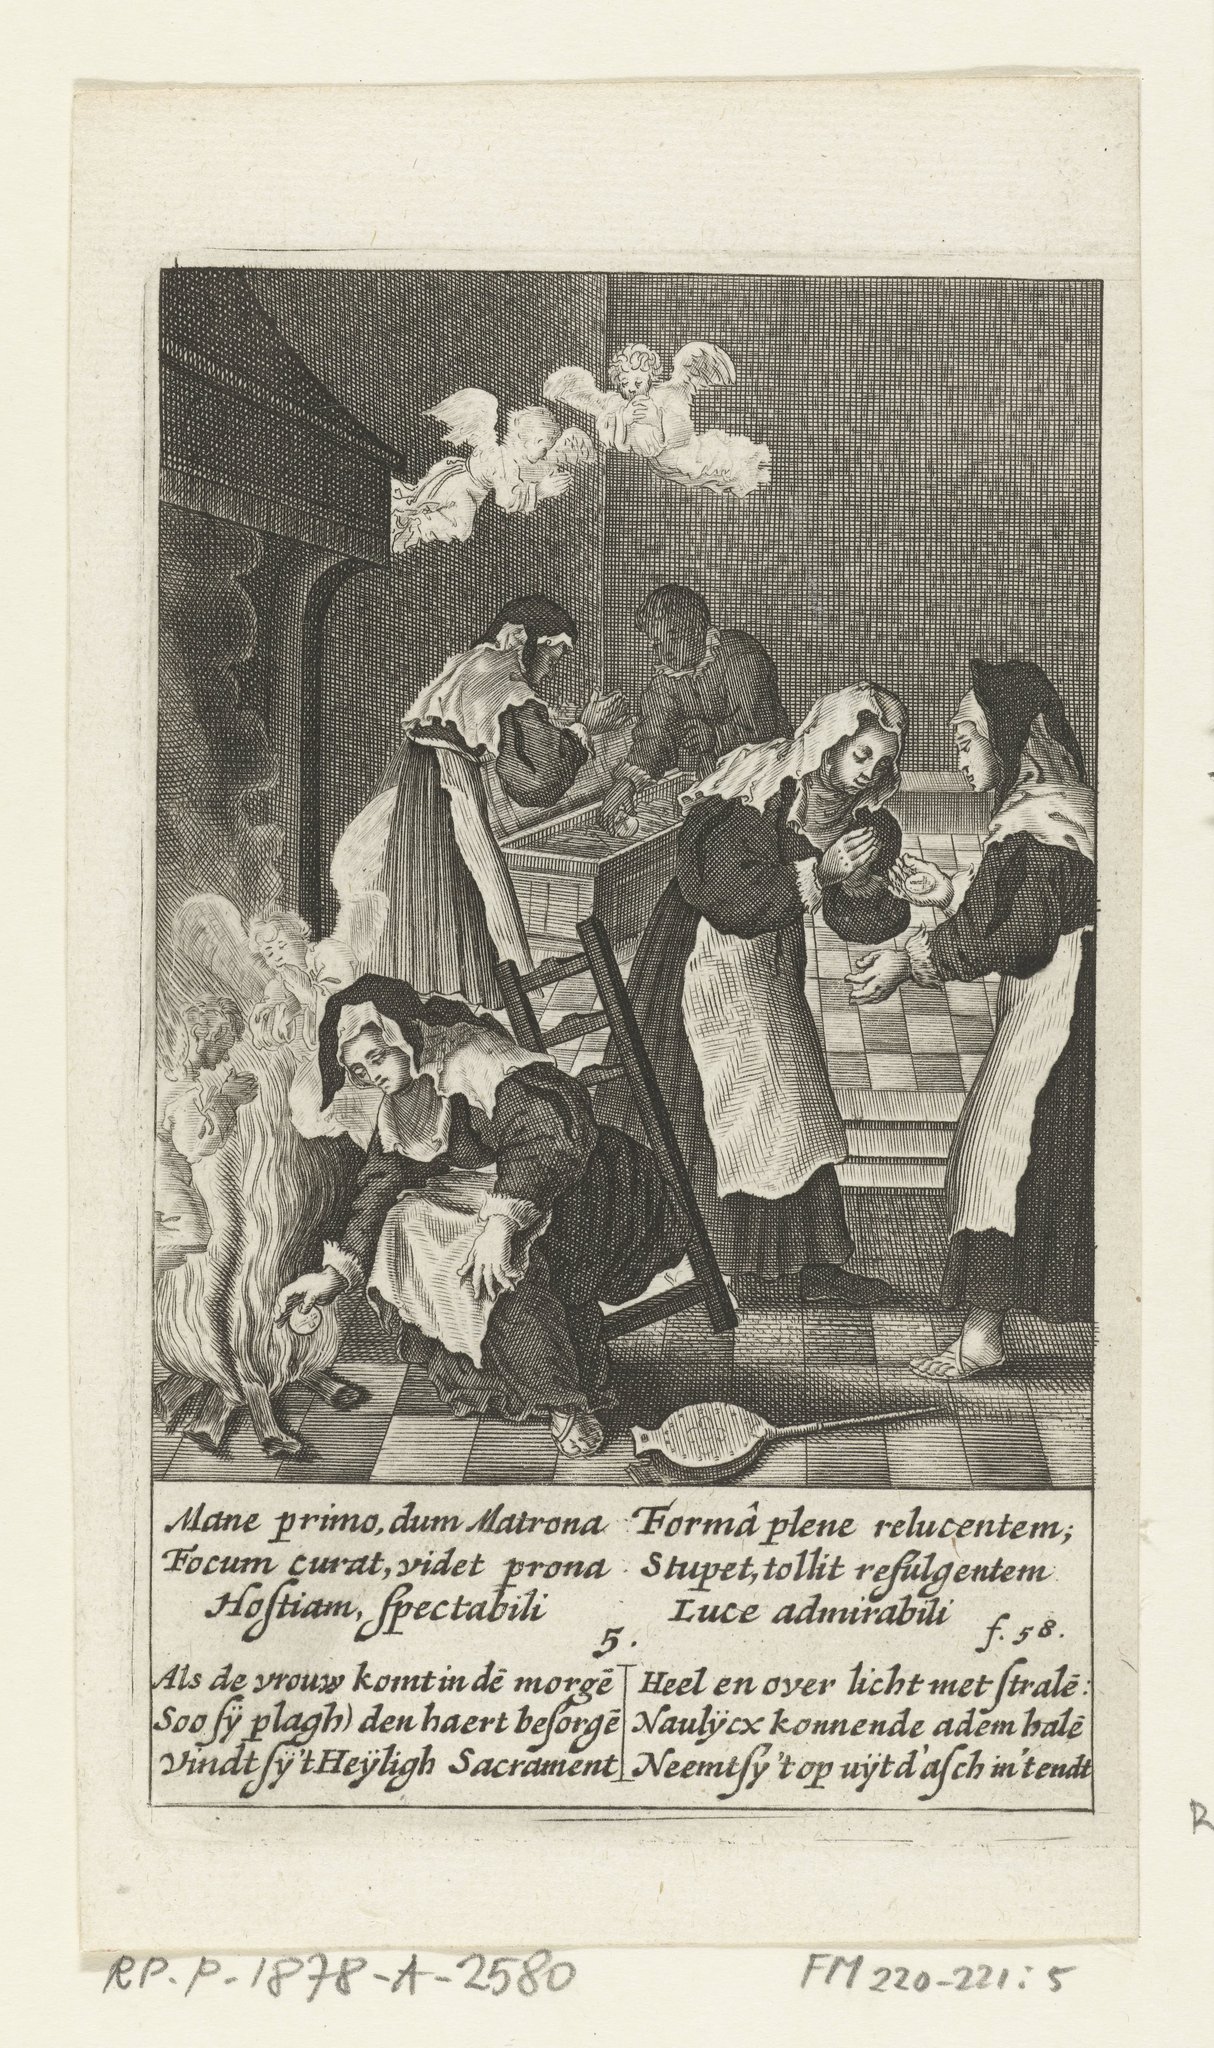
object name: history print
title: Amstelredams eer ende opcomen door de denckwaerdighe miraklen aldaer geschied aen ende door het H. Sacrament des Altaers Anno 1345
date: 1639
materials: paper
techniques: engraving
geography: southern netherlands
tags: amsterdam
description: De vrouw raapt de ongeschonden hostie uit het vuur, op de achtergrond toont zij de hostie en wordt het in een kist opgeborgen. Prent nr. 5 uit de serie van 16 voorstellingen van Het Mirakel van Amsterdam, naar de gebeurtenissen op 15 maart 1345. Onder de voorstelling twee zesregelige verzen in het Latijn en Nederlands.